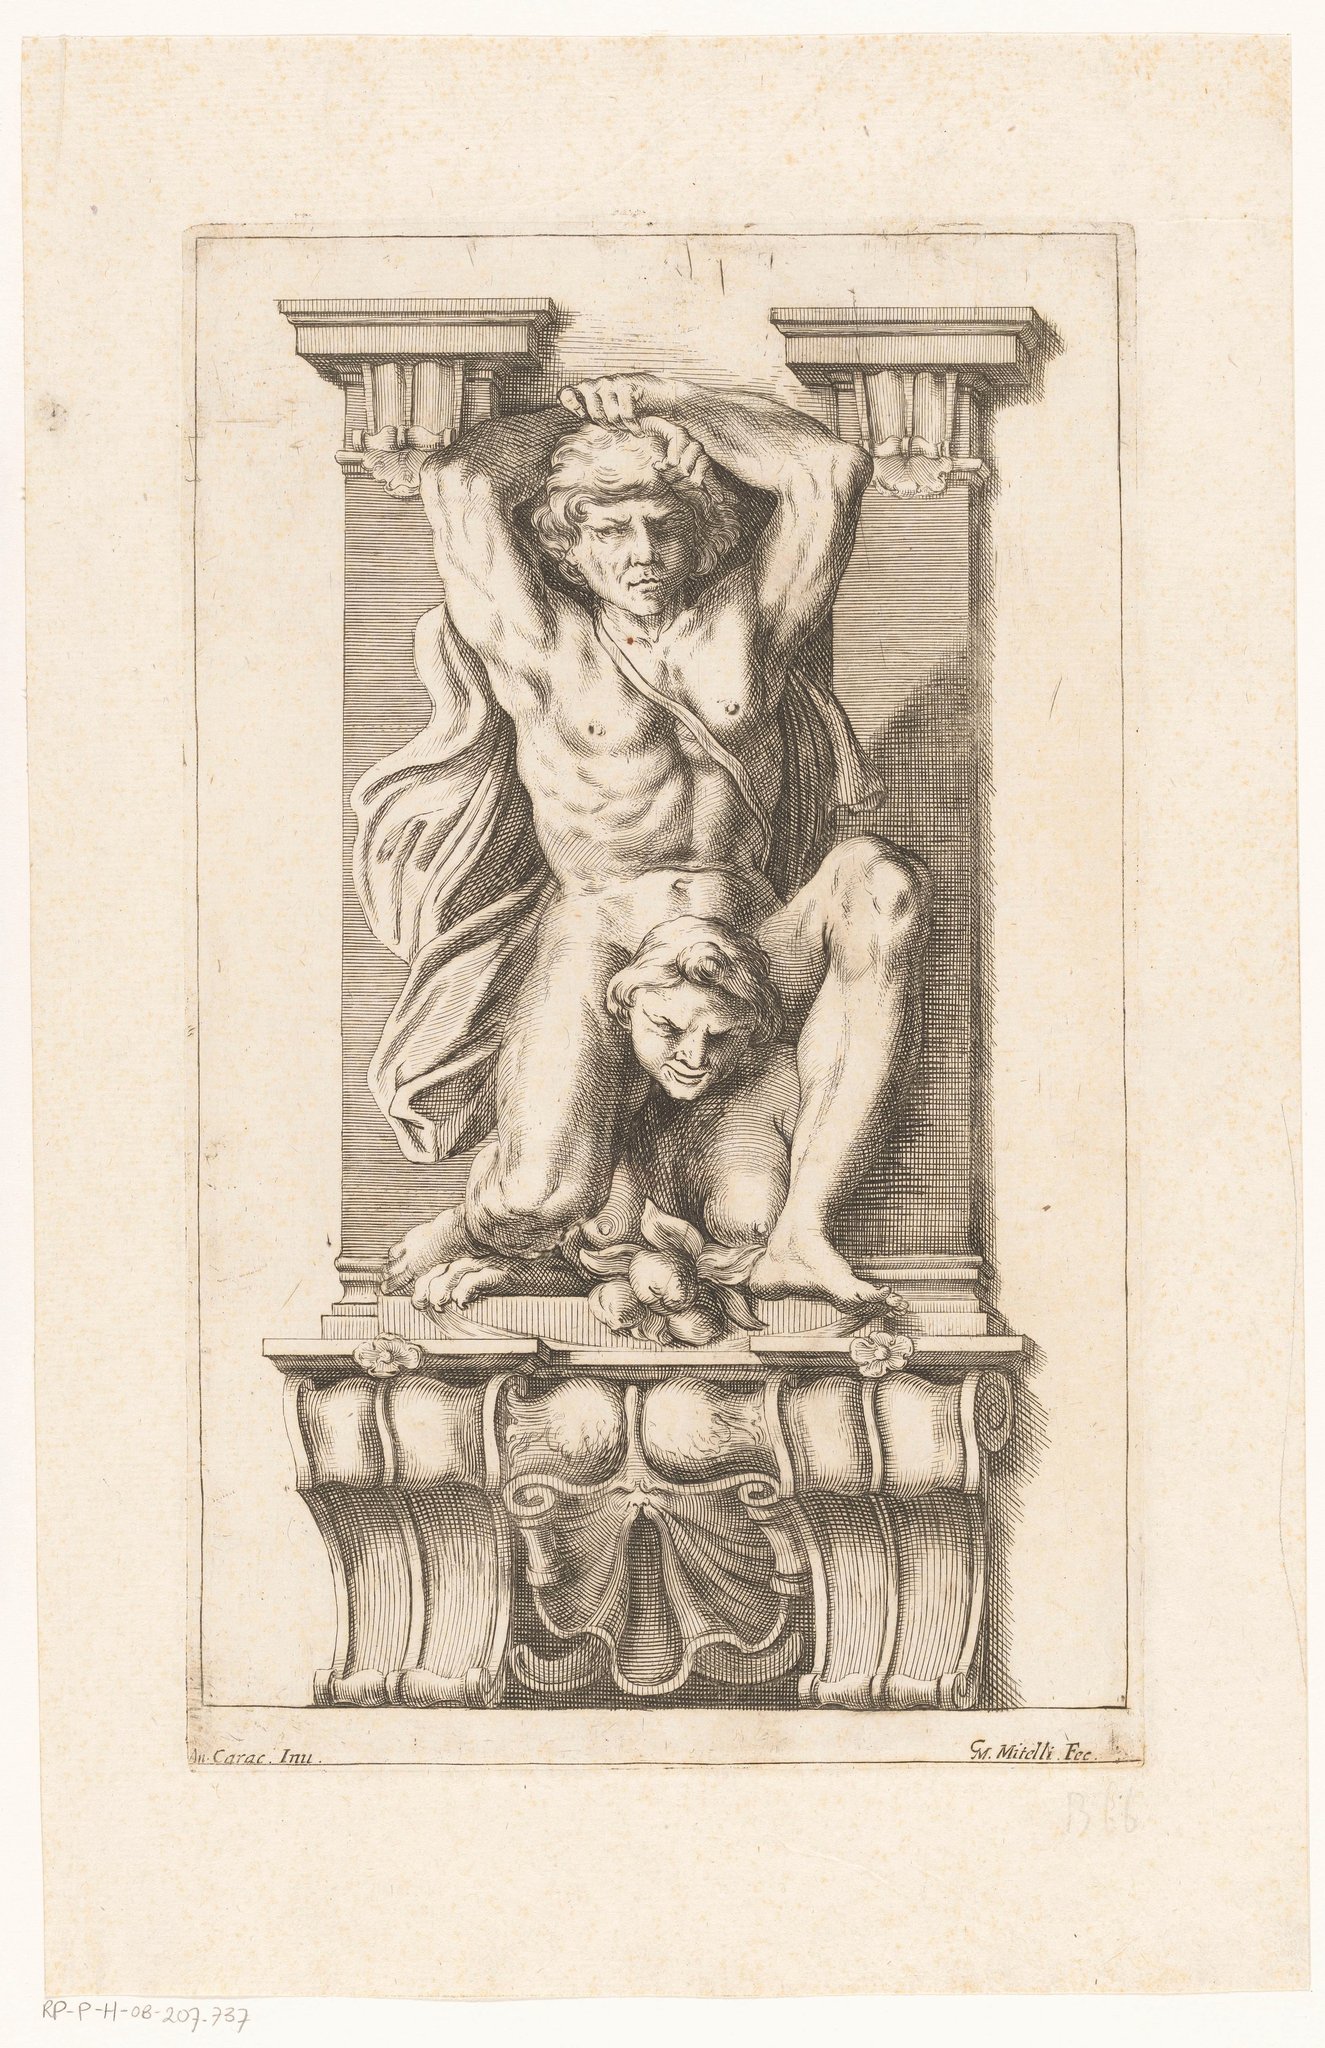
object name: print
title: Man onderwerpt een harpij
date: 1663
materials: paper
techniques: etching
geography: rome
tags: the (nude) human figure; 'corpo humano' (ripa), other architectural details (console), harpies (classical mythology)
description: Deze prent maakt deel uit van een reeks van 20 prenten (+ titelprent) naar de fresco's door de Carracci's in Palazzo Fava Ghisilieri te Bologna. Deze prent maakte oorspronkelijk deel uit van liber nr. 22 van de Atlas van Rome, uit de collectie Hinloopen. In dit album waren een aantal prentreeksen naar bekende zeventiende eeuwse frescoseries bijeengebonden. In 1709 heeft Schijnvoet op last van de burgemeesters van Amsterdam de collectie herordend. De prenten uit liber 22 kwamen terrecht in Schijnvoet boek nr. 10. De laatst gedateerde reeks in het album is gedateerd 1691. Het album moet dus na deze datum gebonden zijn. De band is in de Rijksakademietijd uit elkaar gehaald. De marges van de prenten zijn bij het opbergen in het Rijksprentenkabinet vaak drastisch afgesneden. Van een aantal series waren de prenten teruggeslagen om in het album te passen. (Zie: Waals, Jan van der. De prentschat van Michiel Hinloopen. 's-Gravenhage: SDU uitgeverij, 1988, pp. 173-174.)